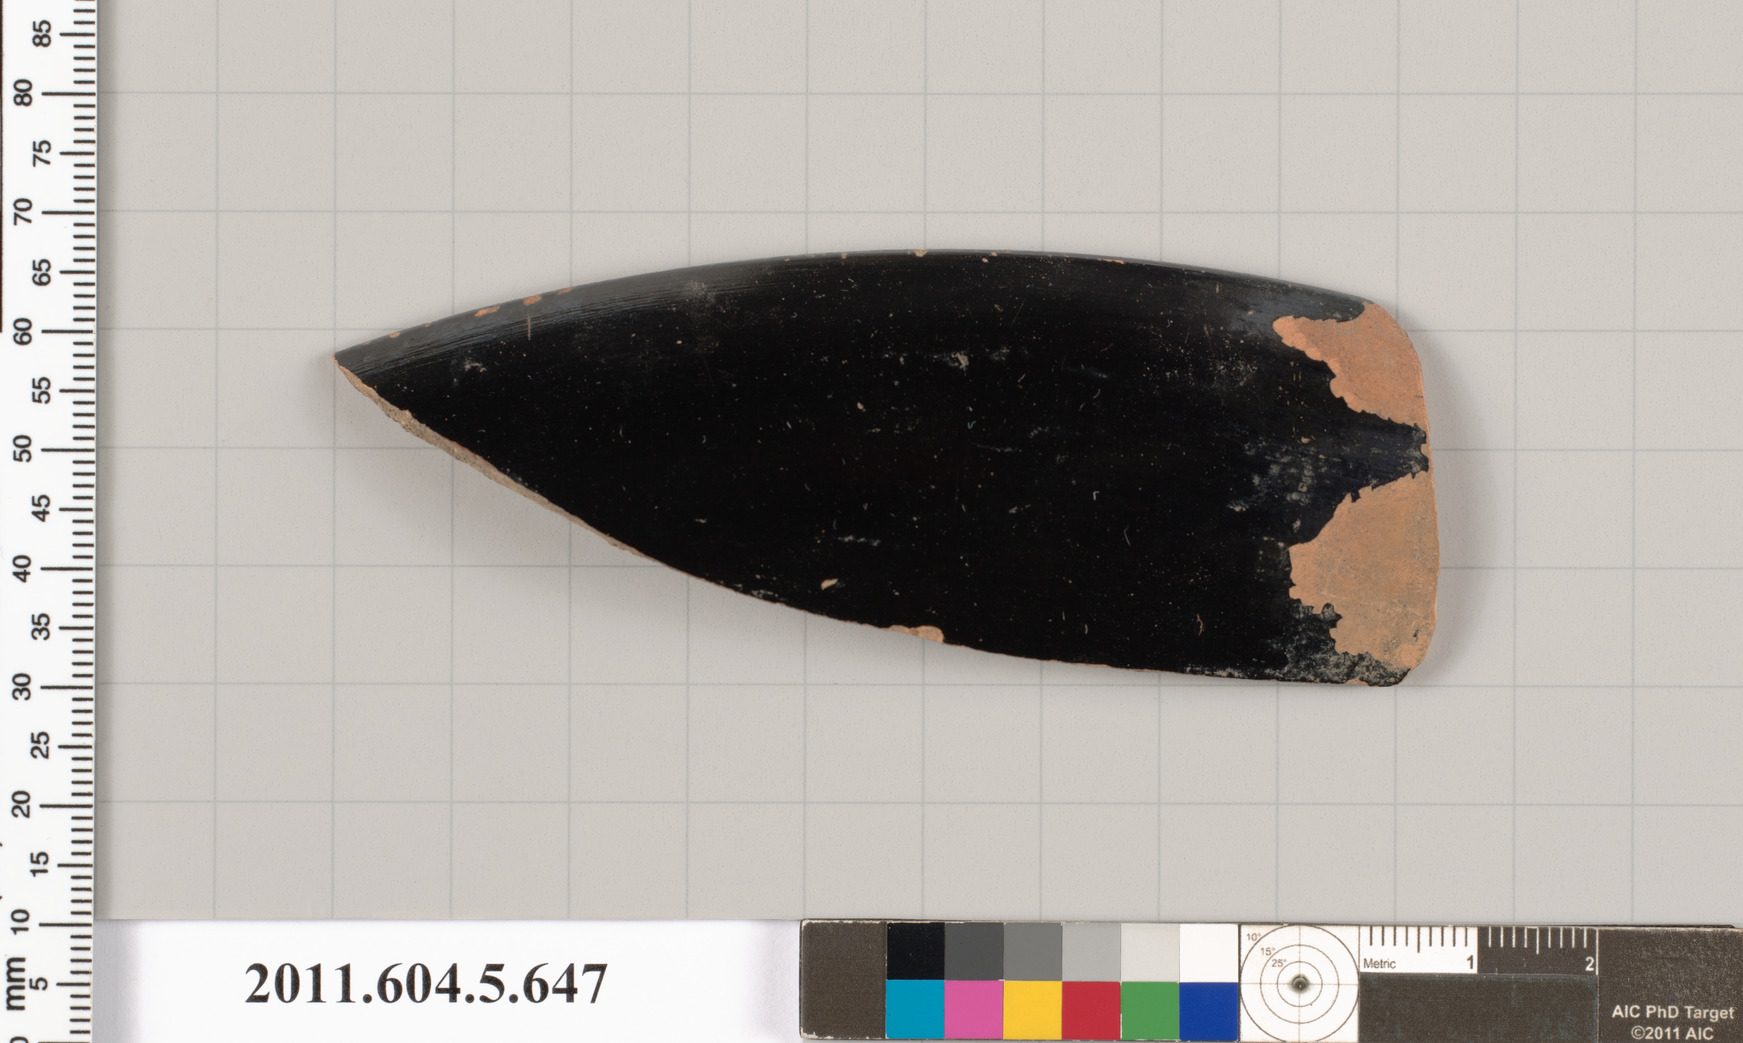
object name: kylix fragment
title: Terracotta rim fragment of a kylix (drinking cup)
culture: greek, attic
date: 600-401 BCE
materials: terracotta